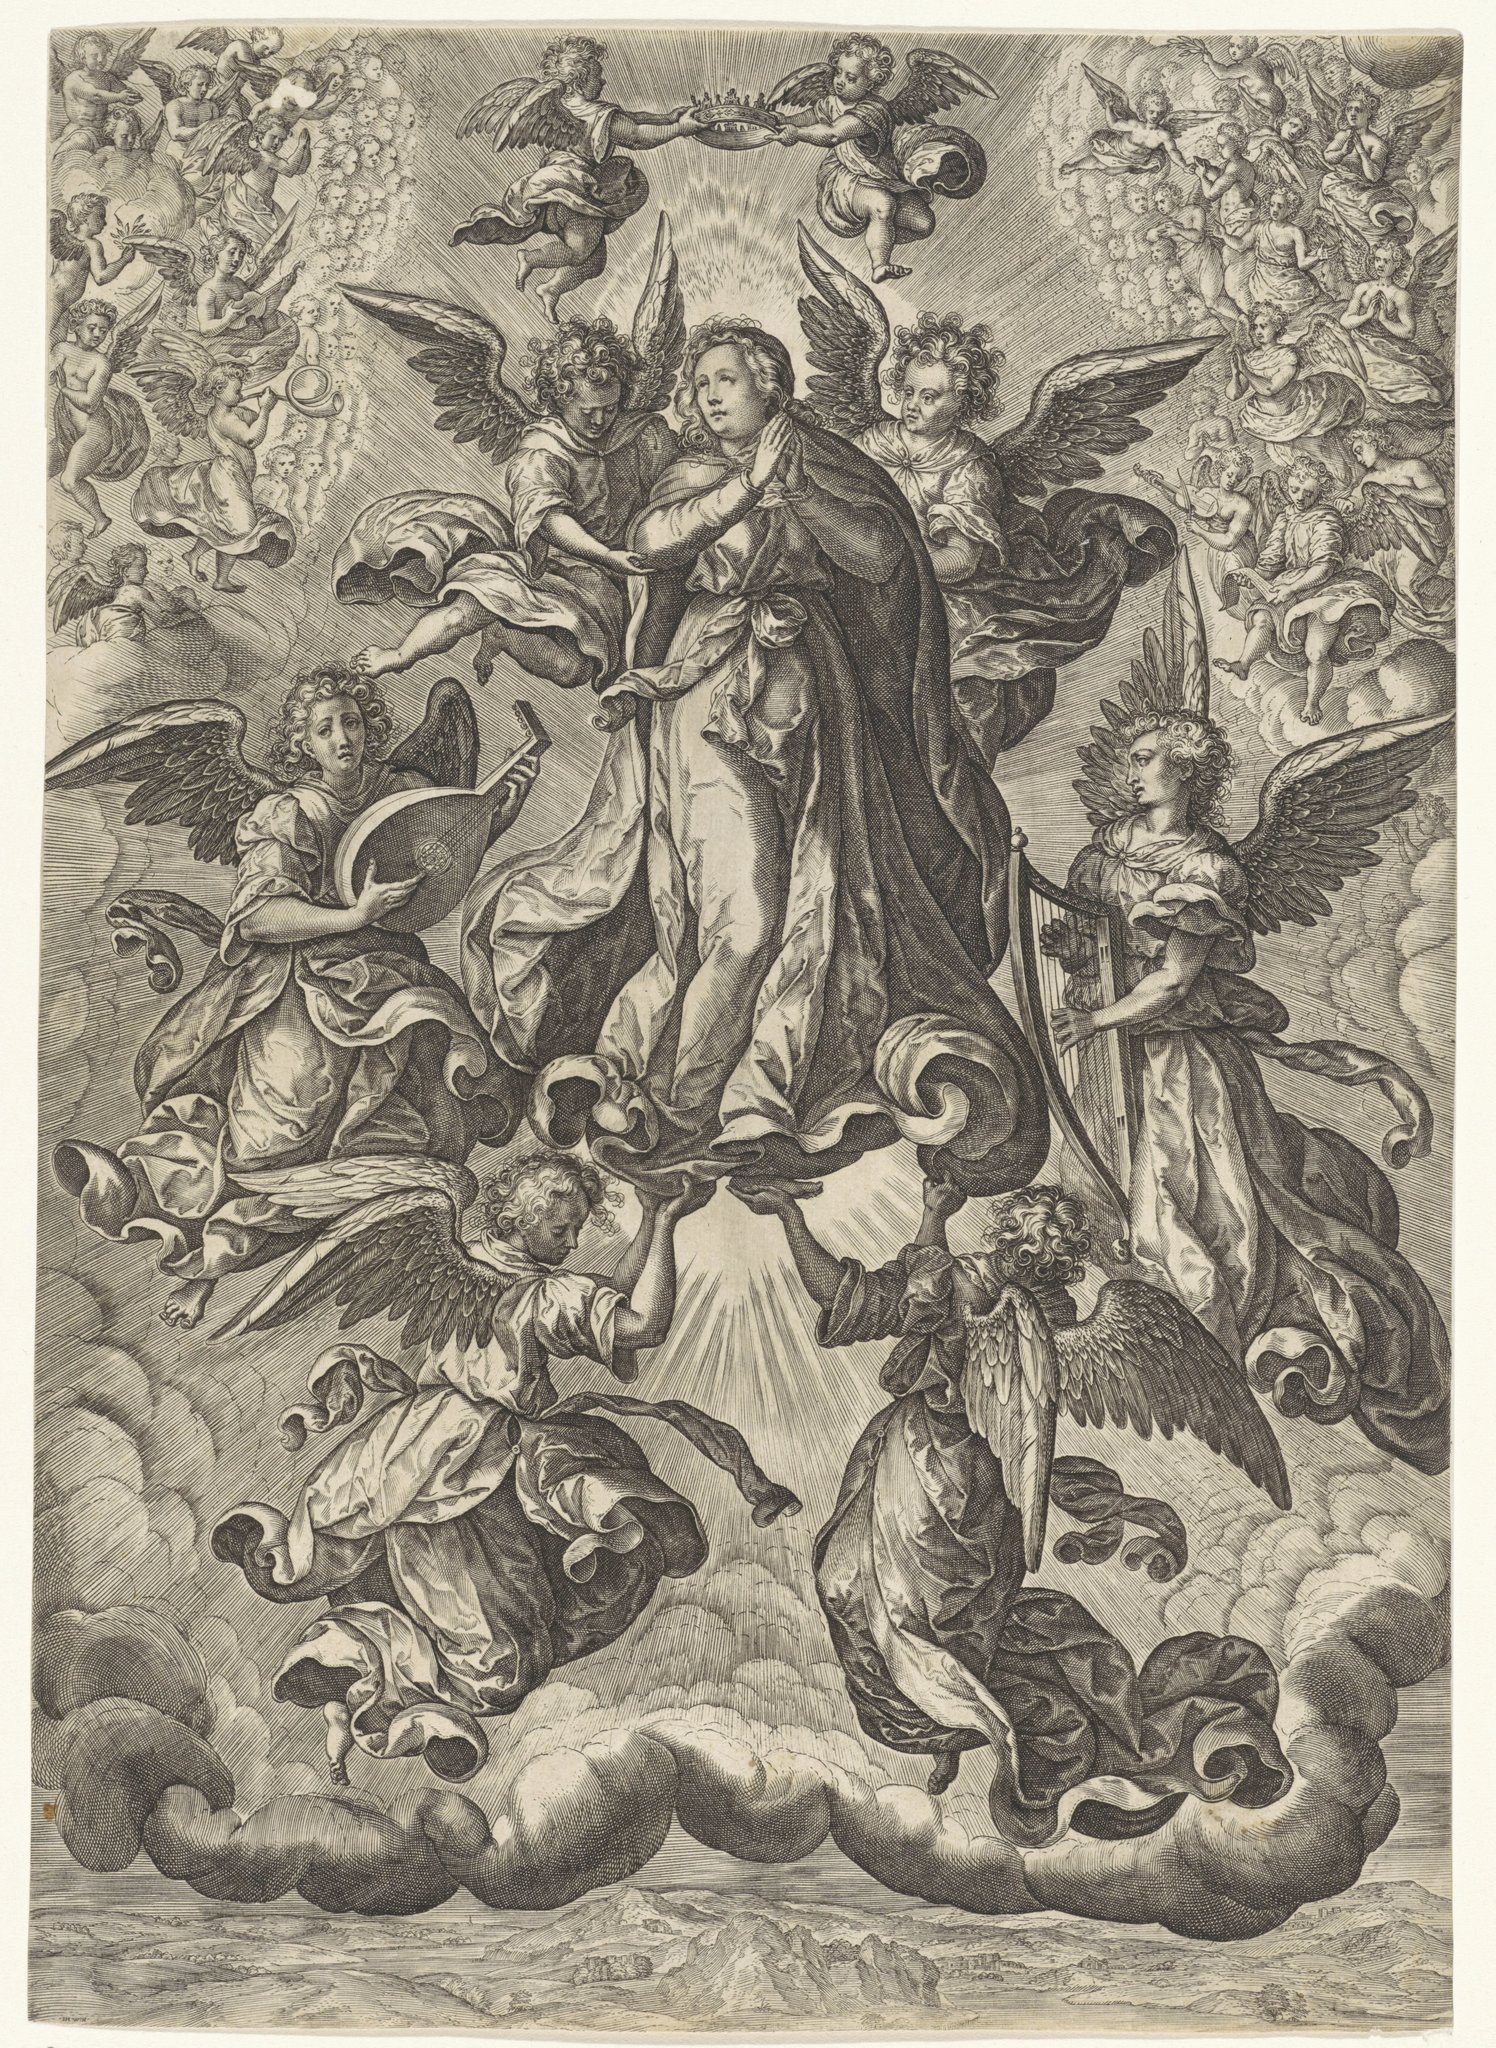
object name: print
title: Hemelvaart van Maria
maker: johannes wierix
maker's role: draughtsman, print maker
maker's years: 1549-1618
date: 1559-1620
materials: paper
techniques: engraving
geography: antwerp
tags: the assumption of mary ('assumptio corporis'): she is borne into heaven by angels (+ angel(s))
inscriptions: collector's mark: Lugt 2228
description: Maria wordt door vier engelen ten hemel gevoerd. Boven haar twee engeltjes met een kroon. In de bovenhoeken musicerende en aanbiddende engelen. Onderaan een bergachtig landschap.